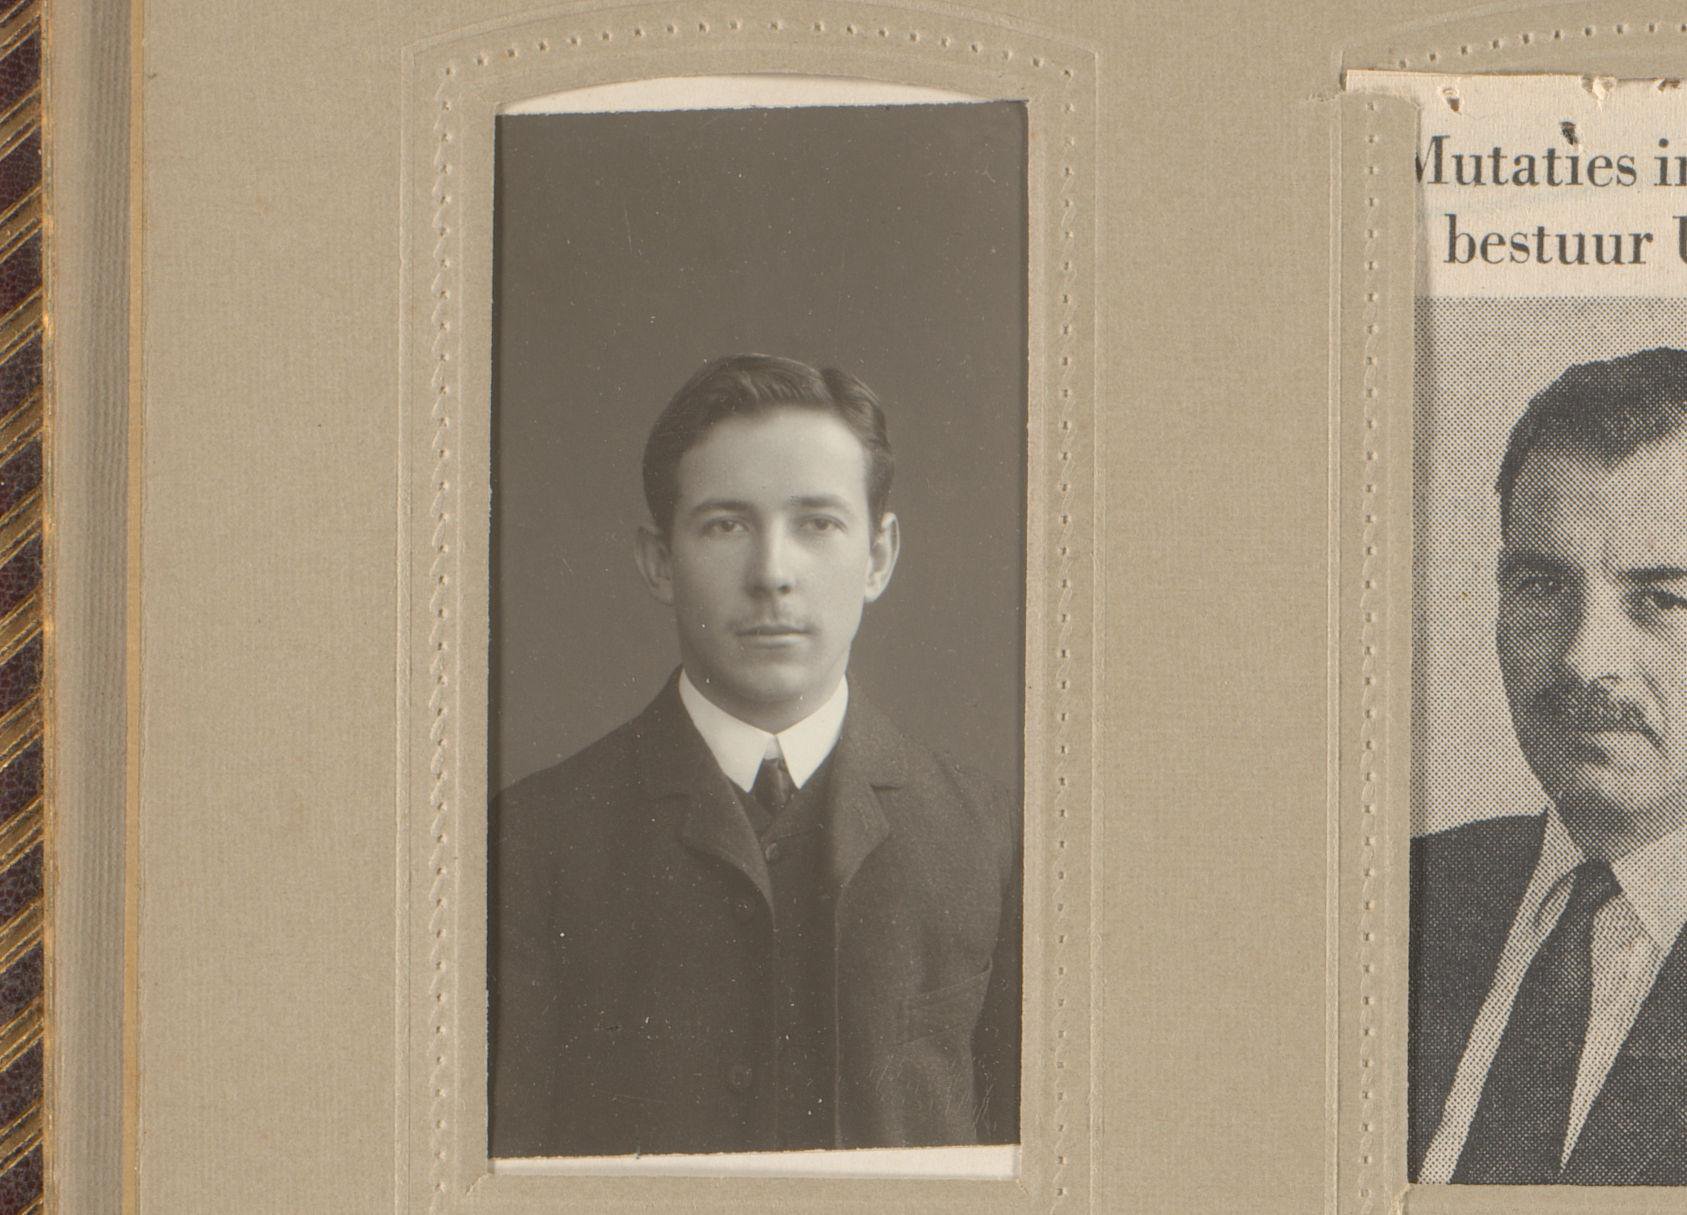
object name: carte de visite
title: Studioportret van G.A. ('Dolph') Kessler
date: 1905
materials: paper, photographic support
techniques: gelatin silver print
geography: netherlands